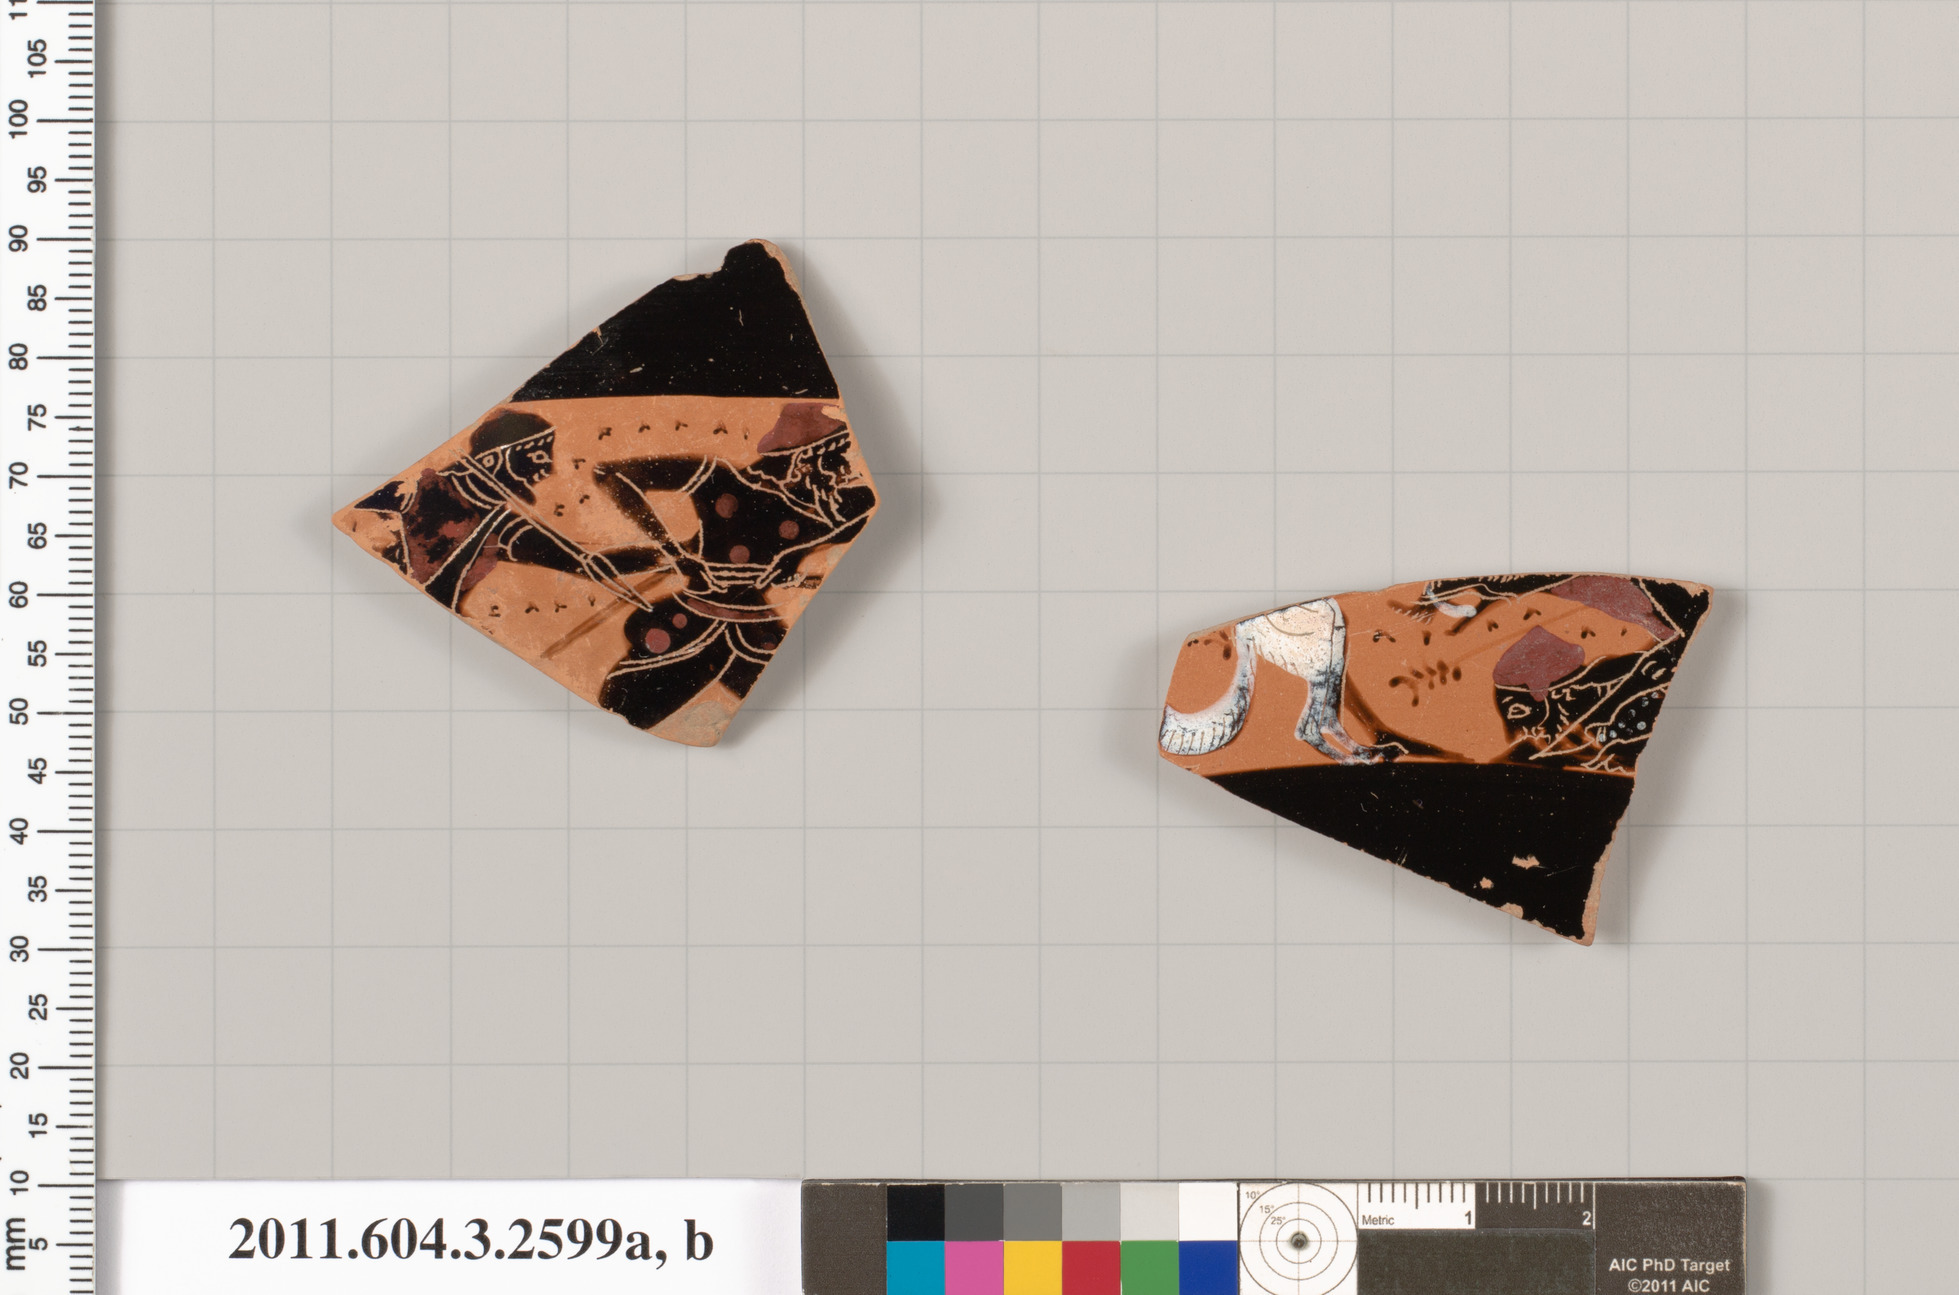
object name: kylix fragment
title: Terracotta fragments of a kylix: Band cup (drinking cup)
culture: greek, attic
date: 550-526 BCE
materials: terracotta